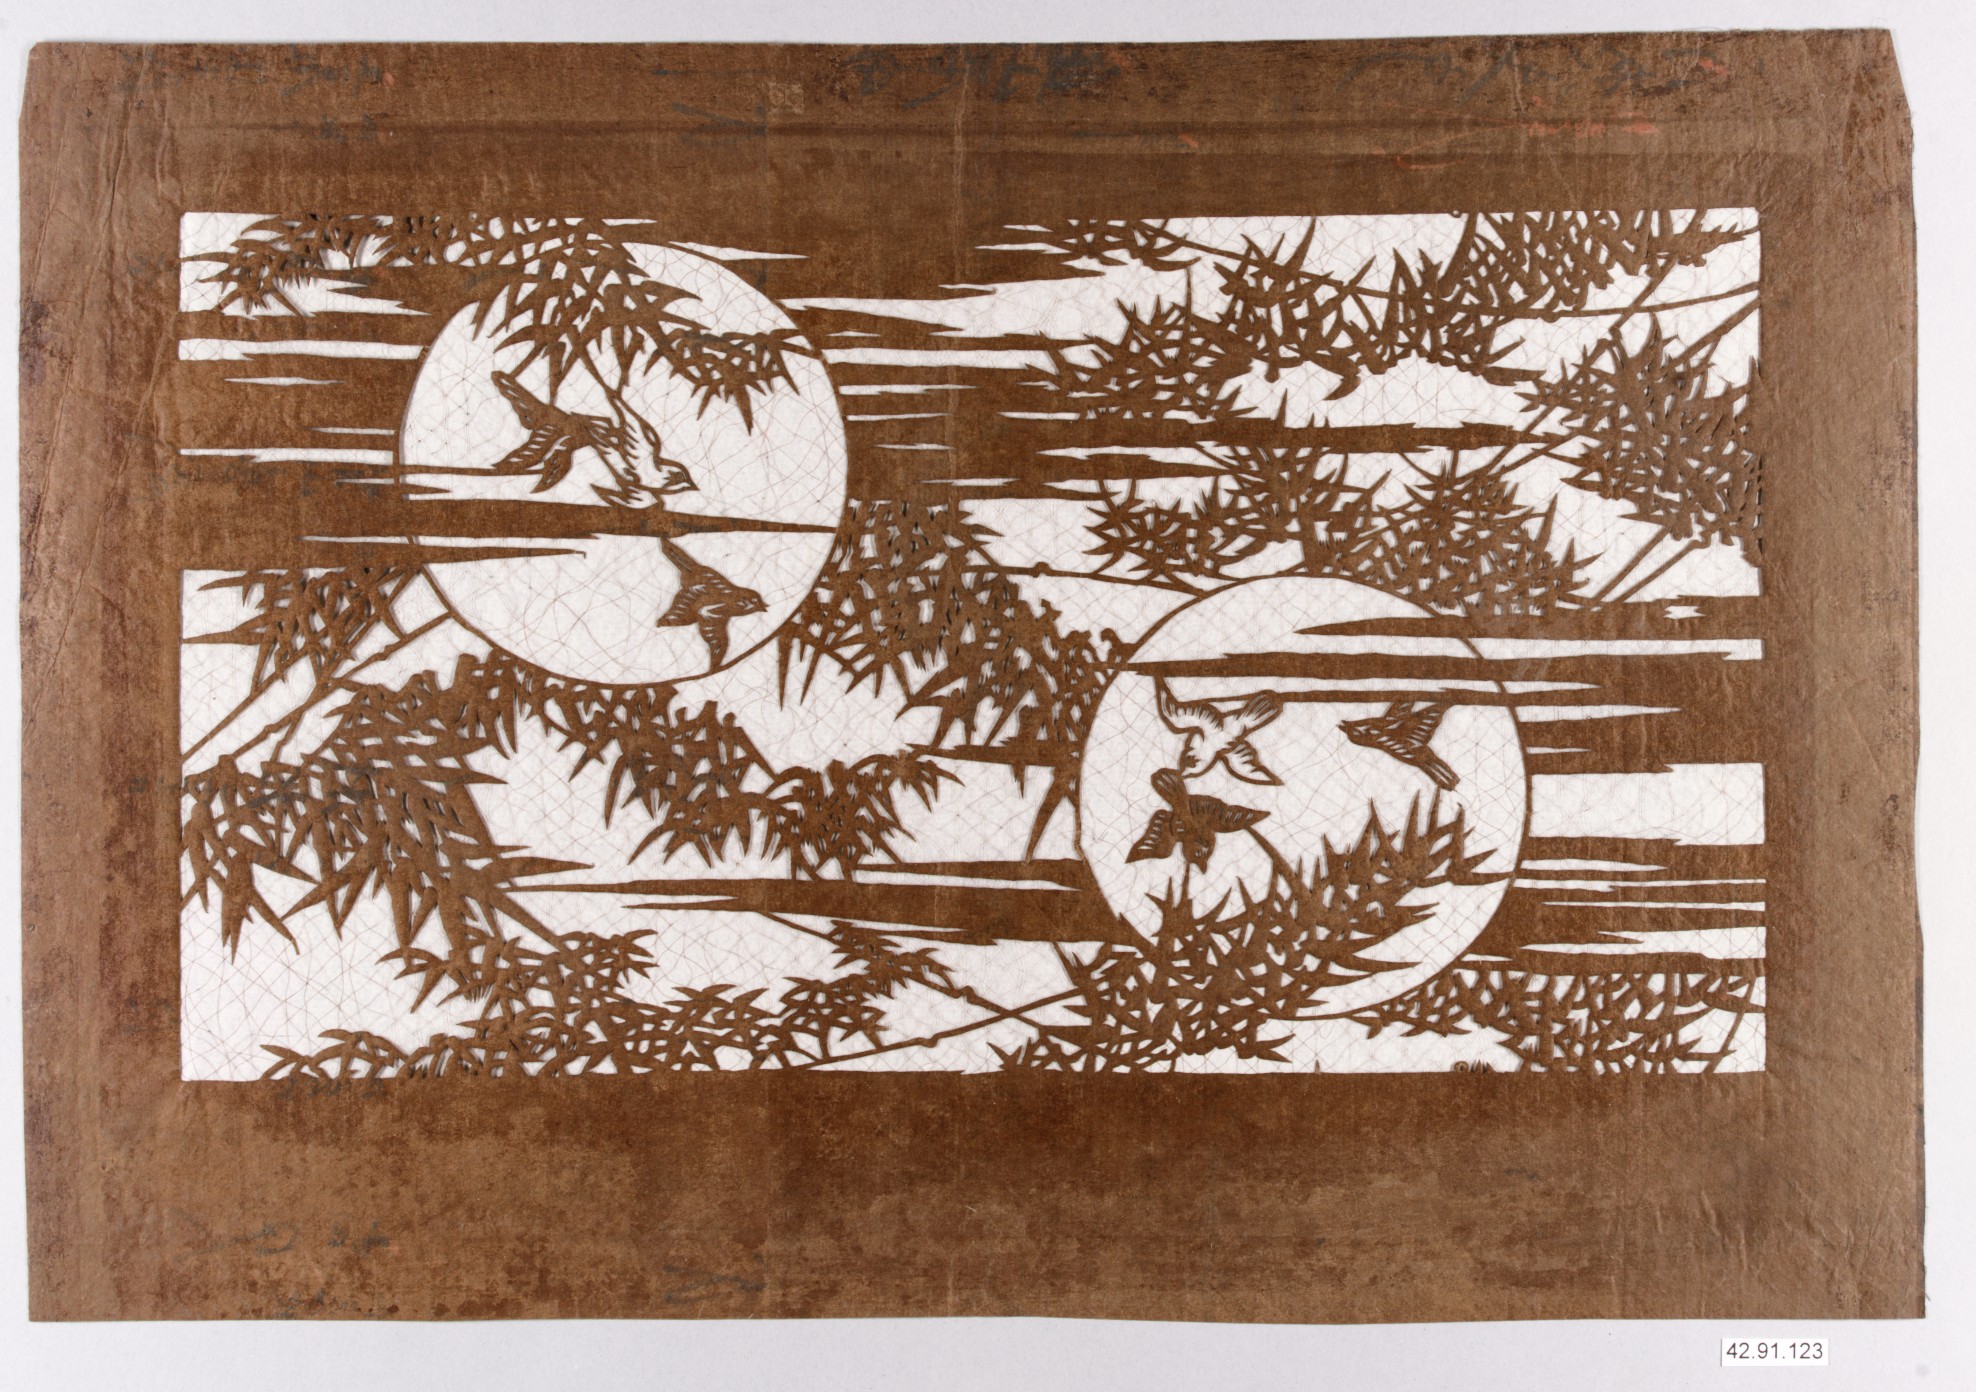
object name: stencil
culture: japanese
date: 1801-1900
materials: paper, silk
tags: birds,moon,bamboo